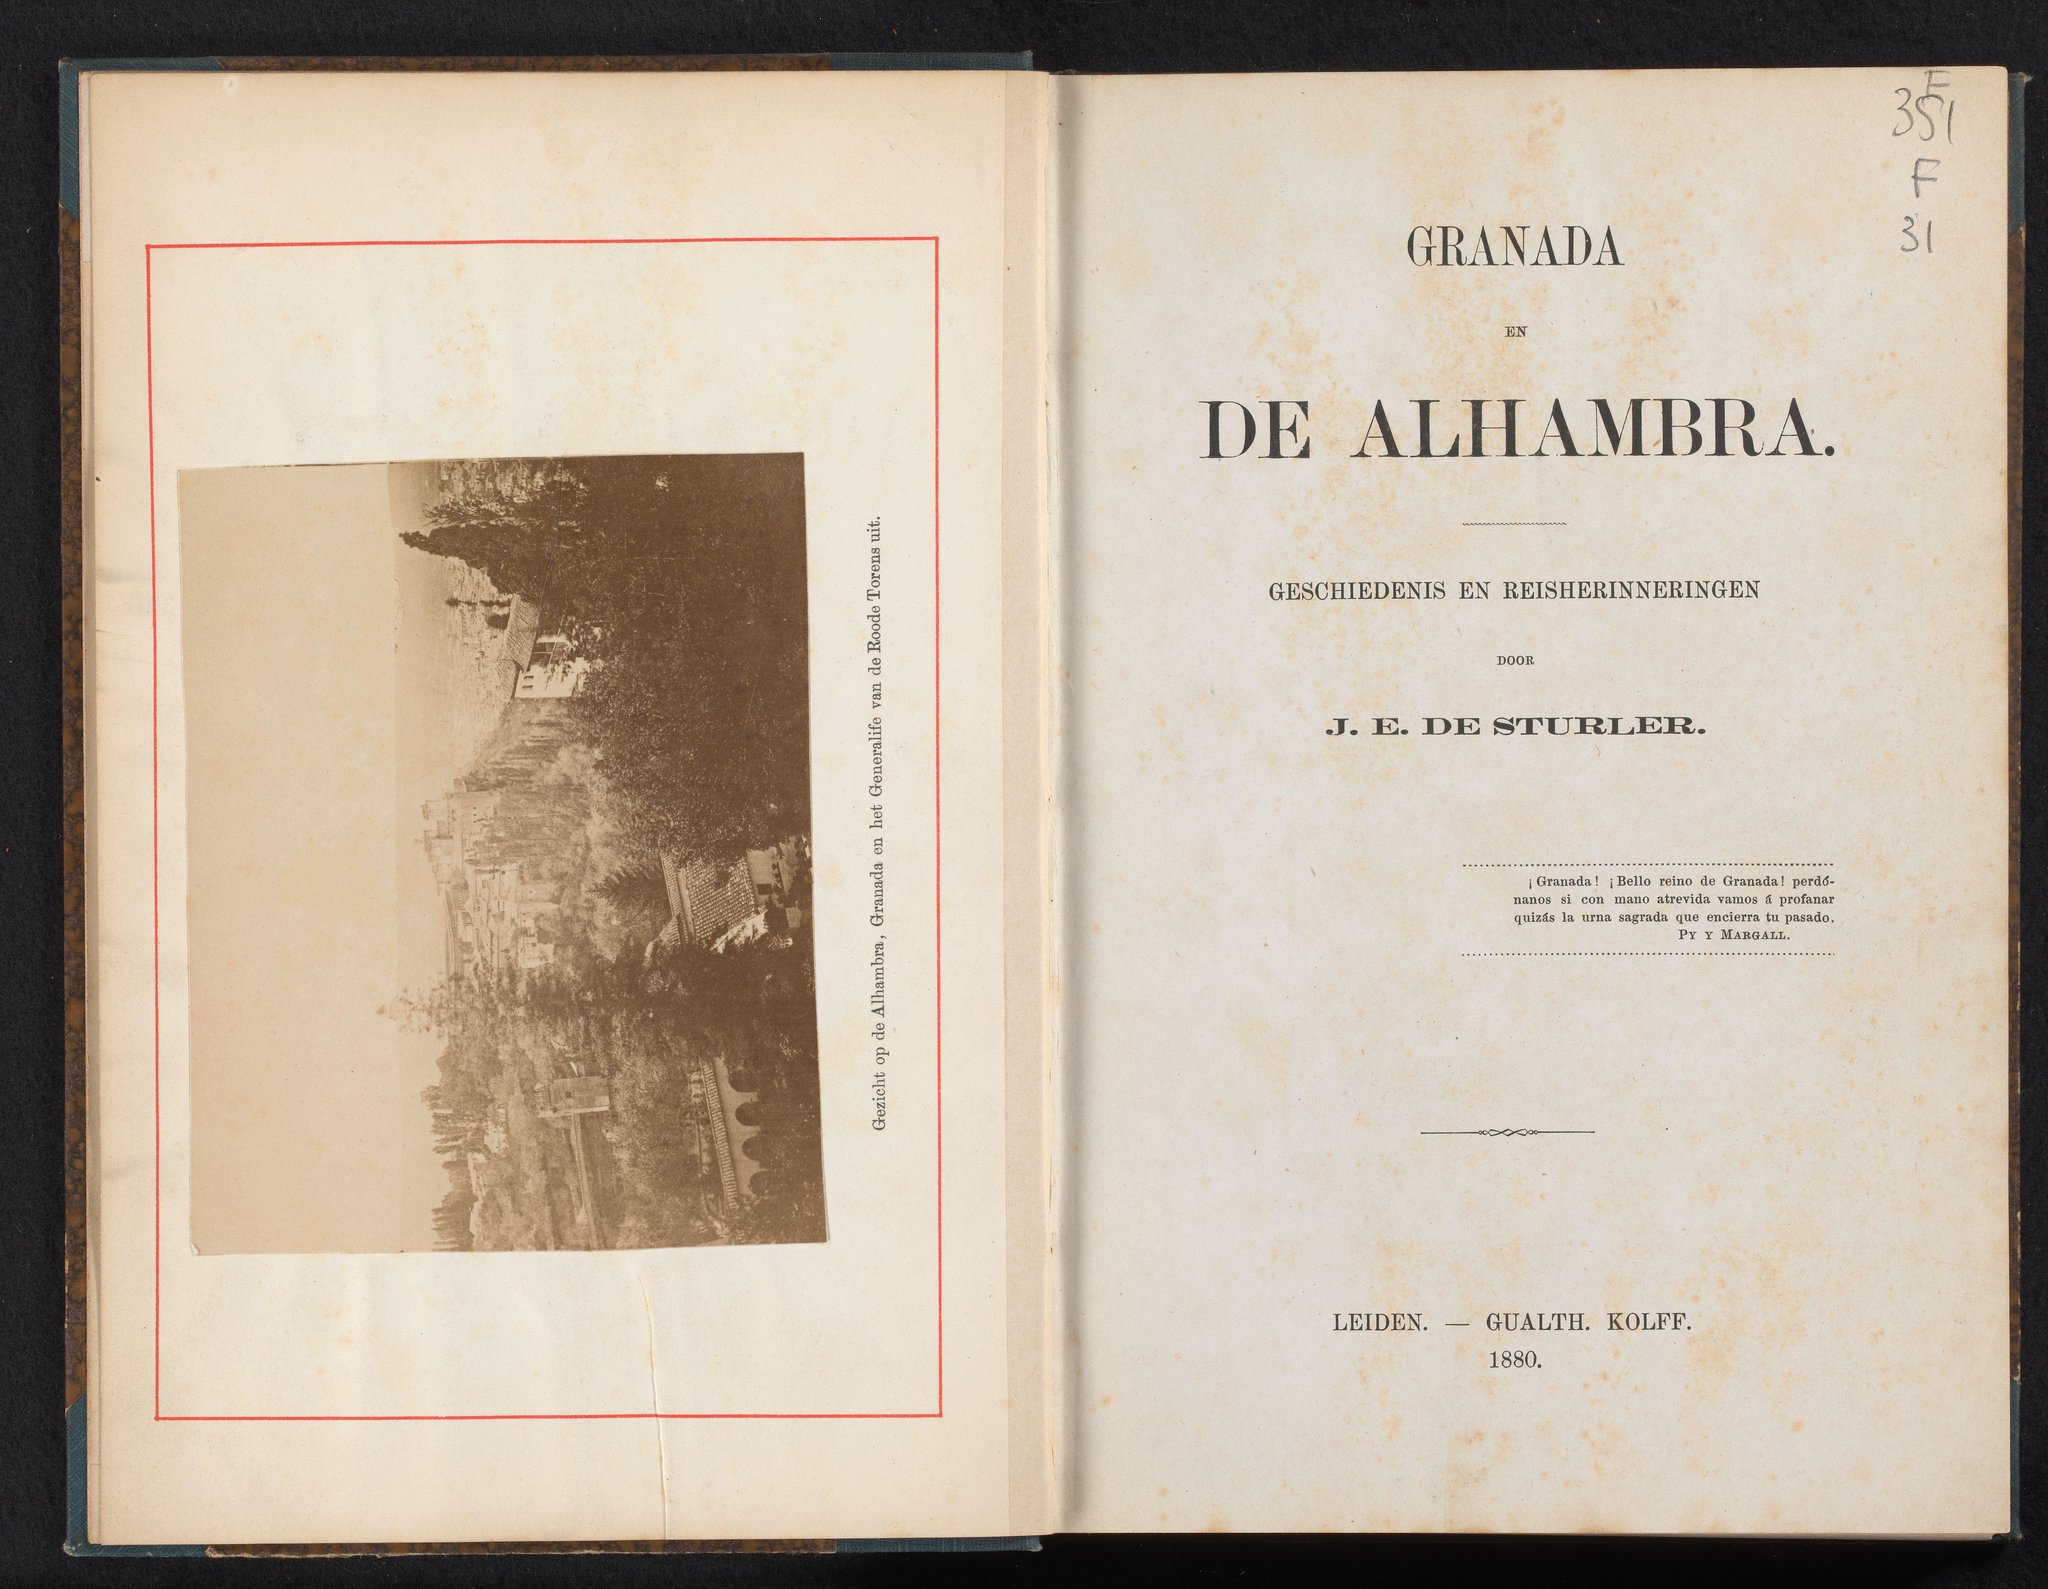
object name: book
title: Granada en de Alhambra : geschiedenis en reisherinneringen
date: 1880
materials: cardboard, linen, paper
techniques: albumen print, lithograph, letterpress printing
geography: leiden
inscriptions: bookplate: ‘Ex/Libris’, inscription: ‘&st [?] 4/5 41/ -35/344’